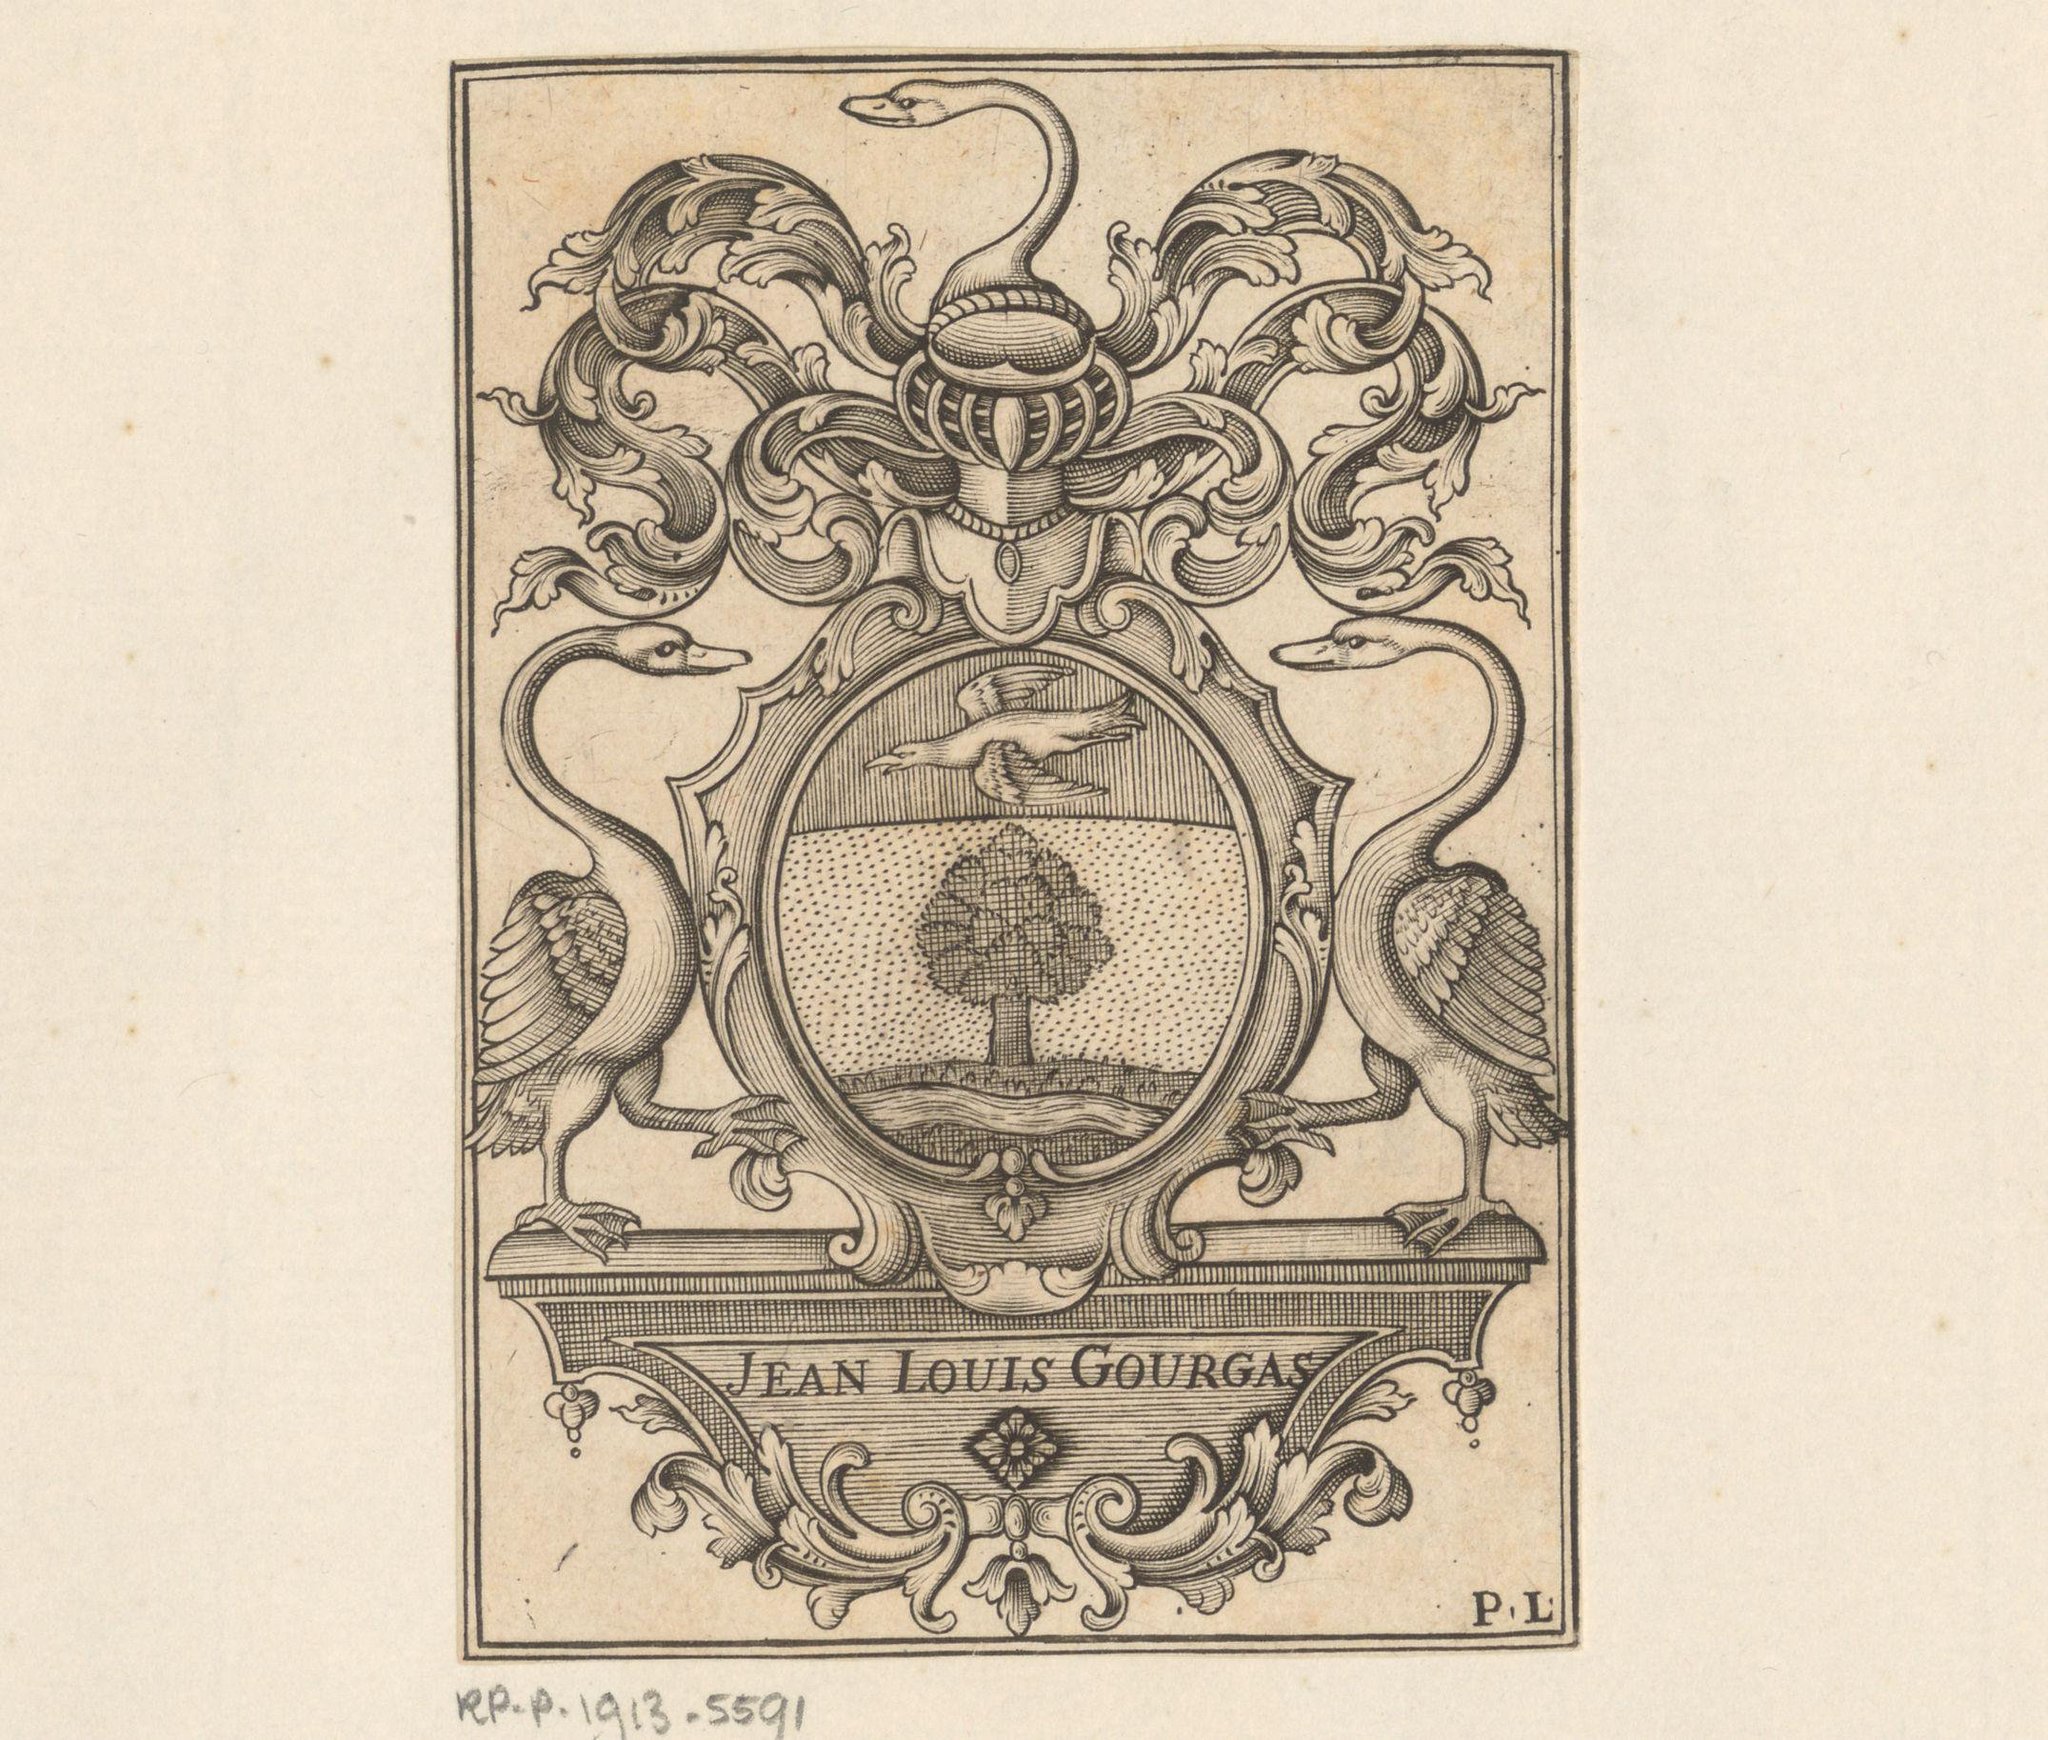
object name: bookplate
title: Ex libris van Jean Louis Gourgas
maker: Anonymous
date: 1755-1855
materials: paper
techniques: engraving, etching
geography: switzerland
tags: trees, water-birds: swan, armorial bearing, heraldry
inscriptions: collector's mark: Lugt 2760, inscription: ‘Gerster 986’, collector's mark: Lugt 2233